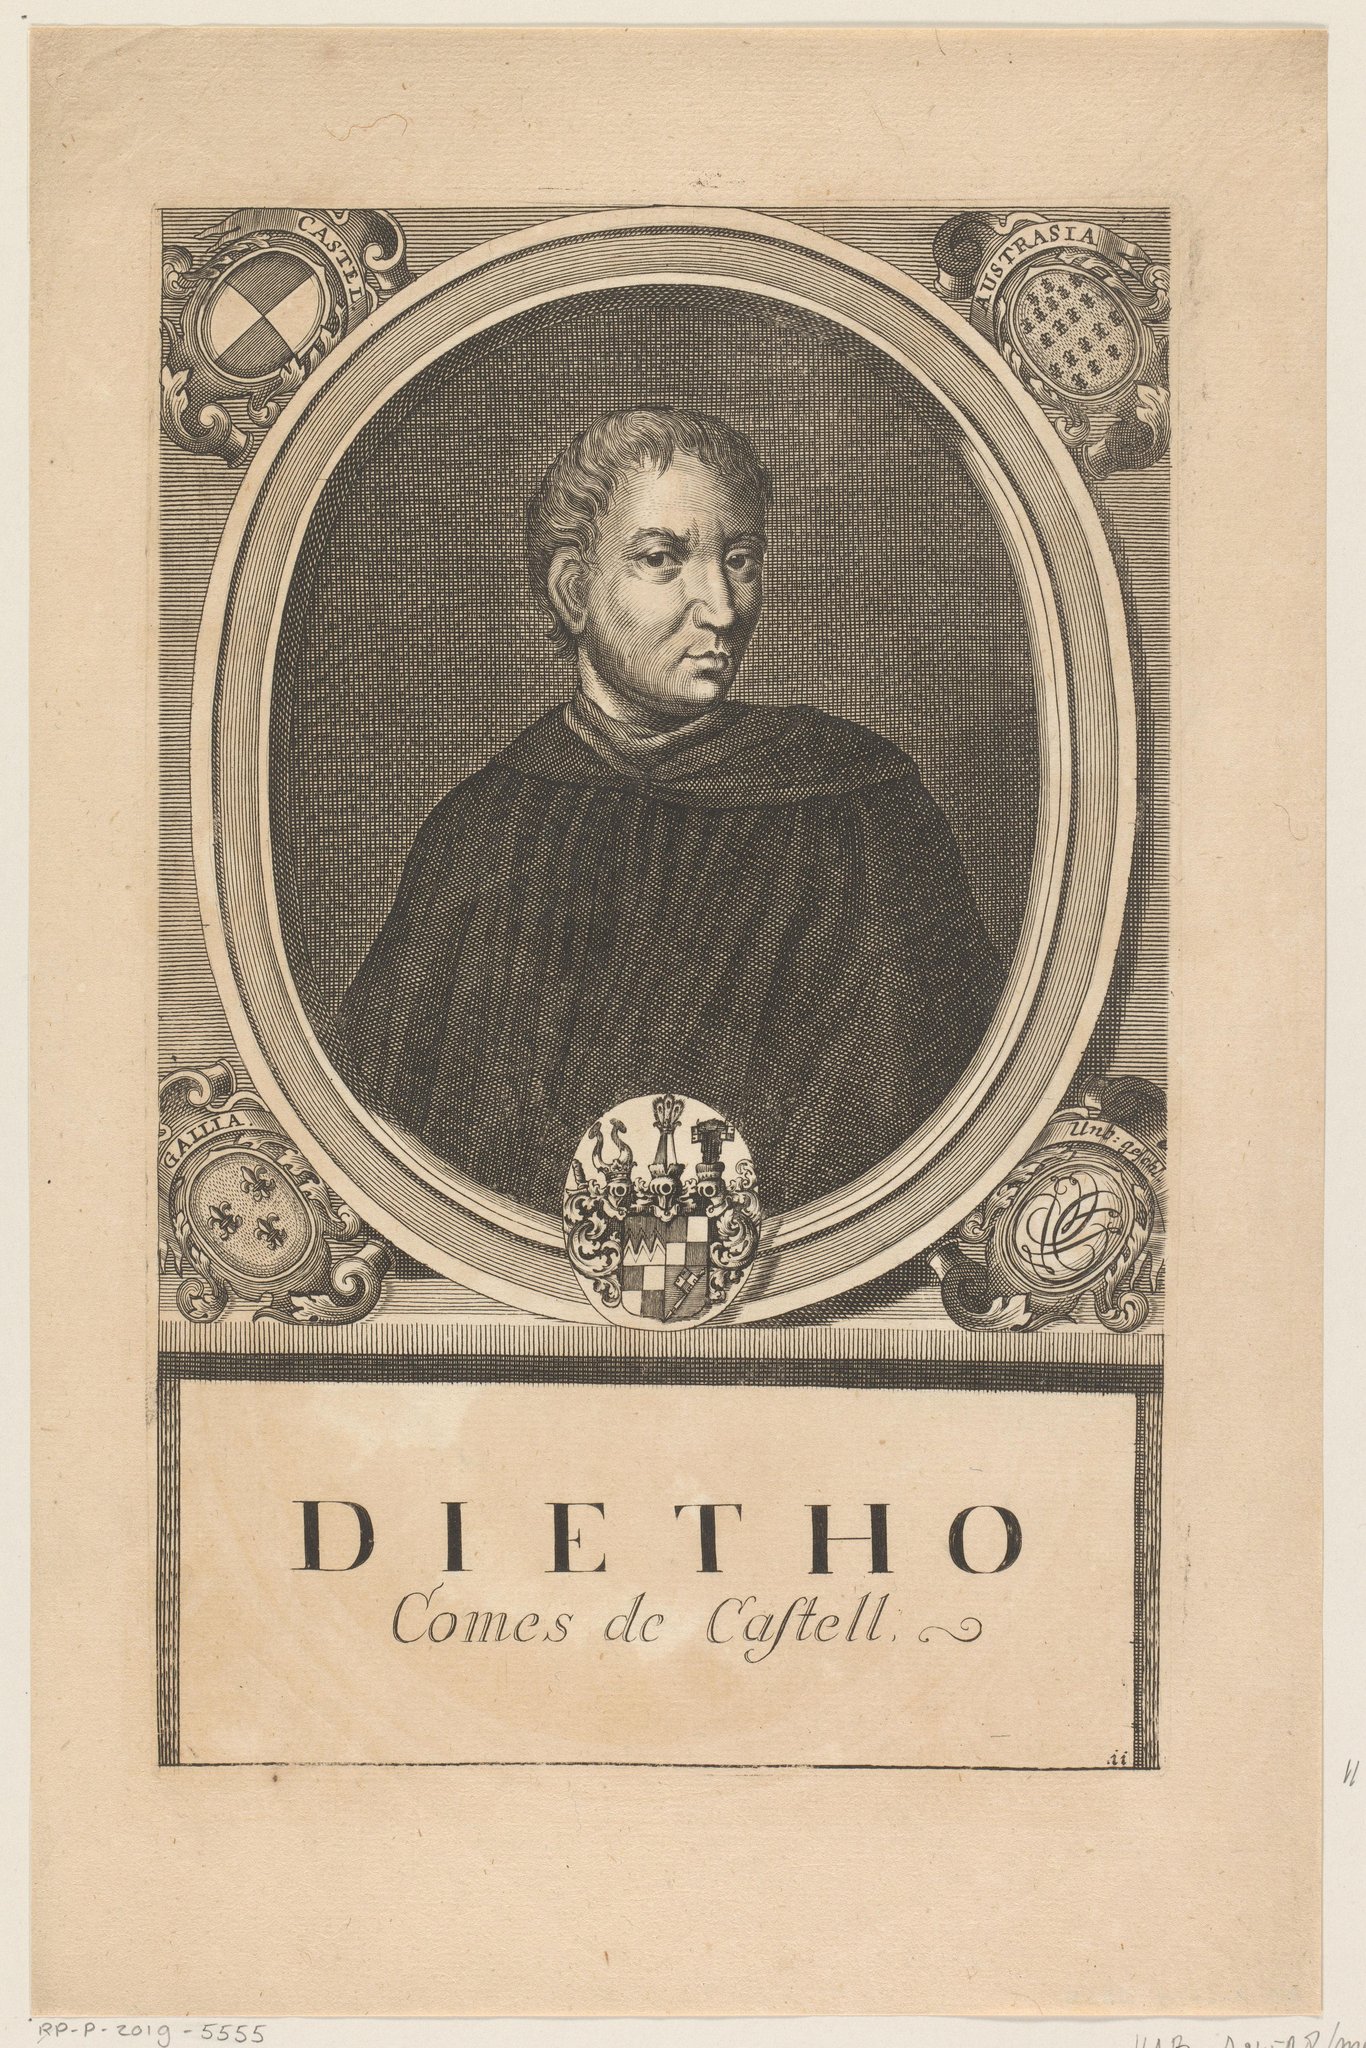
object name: print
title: Portret van Dietho von Castell, bisschop van Würzburg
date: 1713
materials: paper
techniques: engraving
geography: frankfurt am main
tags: archbishop, bishop, etc. (roman catholic), historical persons, armorial bearing, heraldry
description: Prent uit: Ludewig, Johann Peter von. Geschicht-Schreiber von dem Bischoffthum Wirtzburg (...). Frankfurt am Main: Thomas Fritsch, 1713.